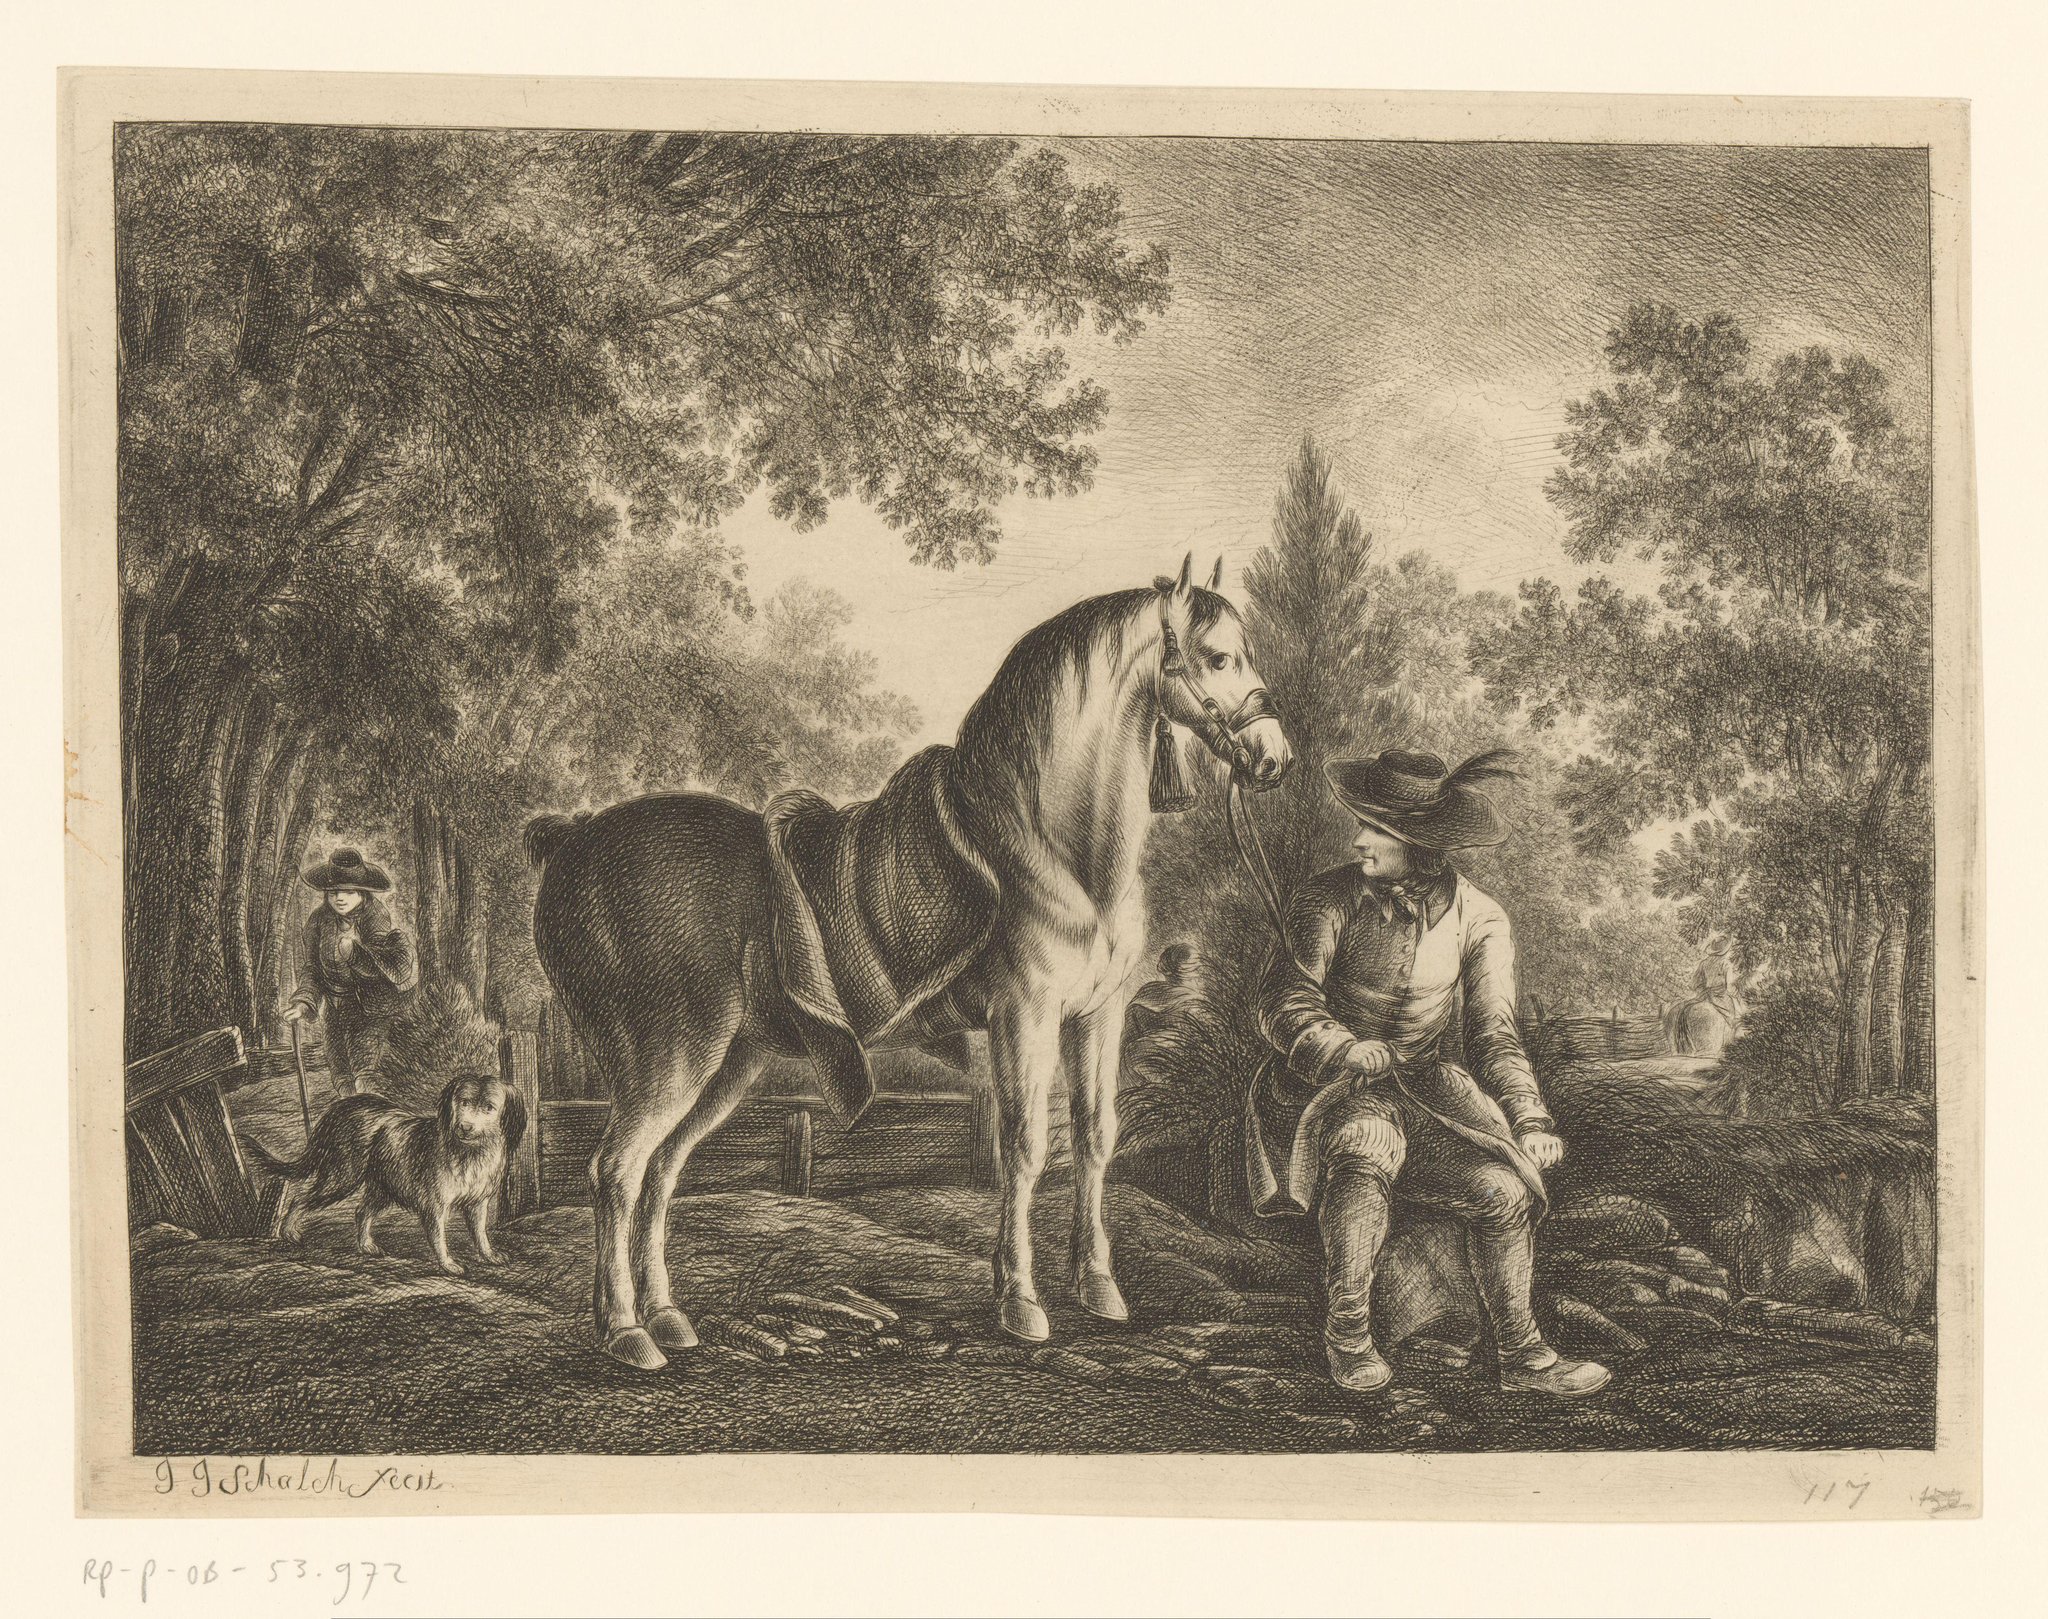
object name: print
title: Paard aan teugel vastgehouden door man zittend op steen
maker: johann jakob schalch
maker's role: print maker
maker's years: 1723-1789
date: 1733-1789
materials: paper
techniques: etching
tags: riding a horse, ass, or mule; rider, horseman, horse, dog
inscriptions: collector's mark: Lugt 240